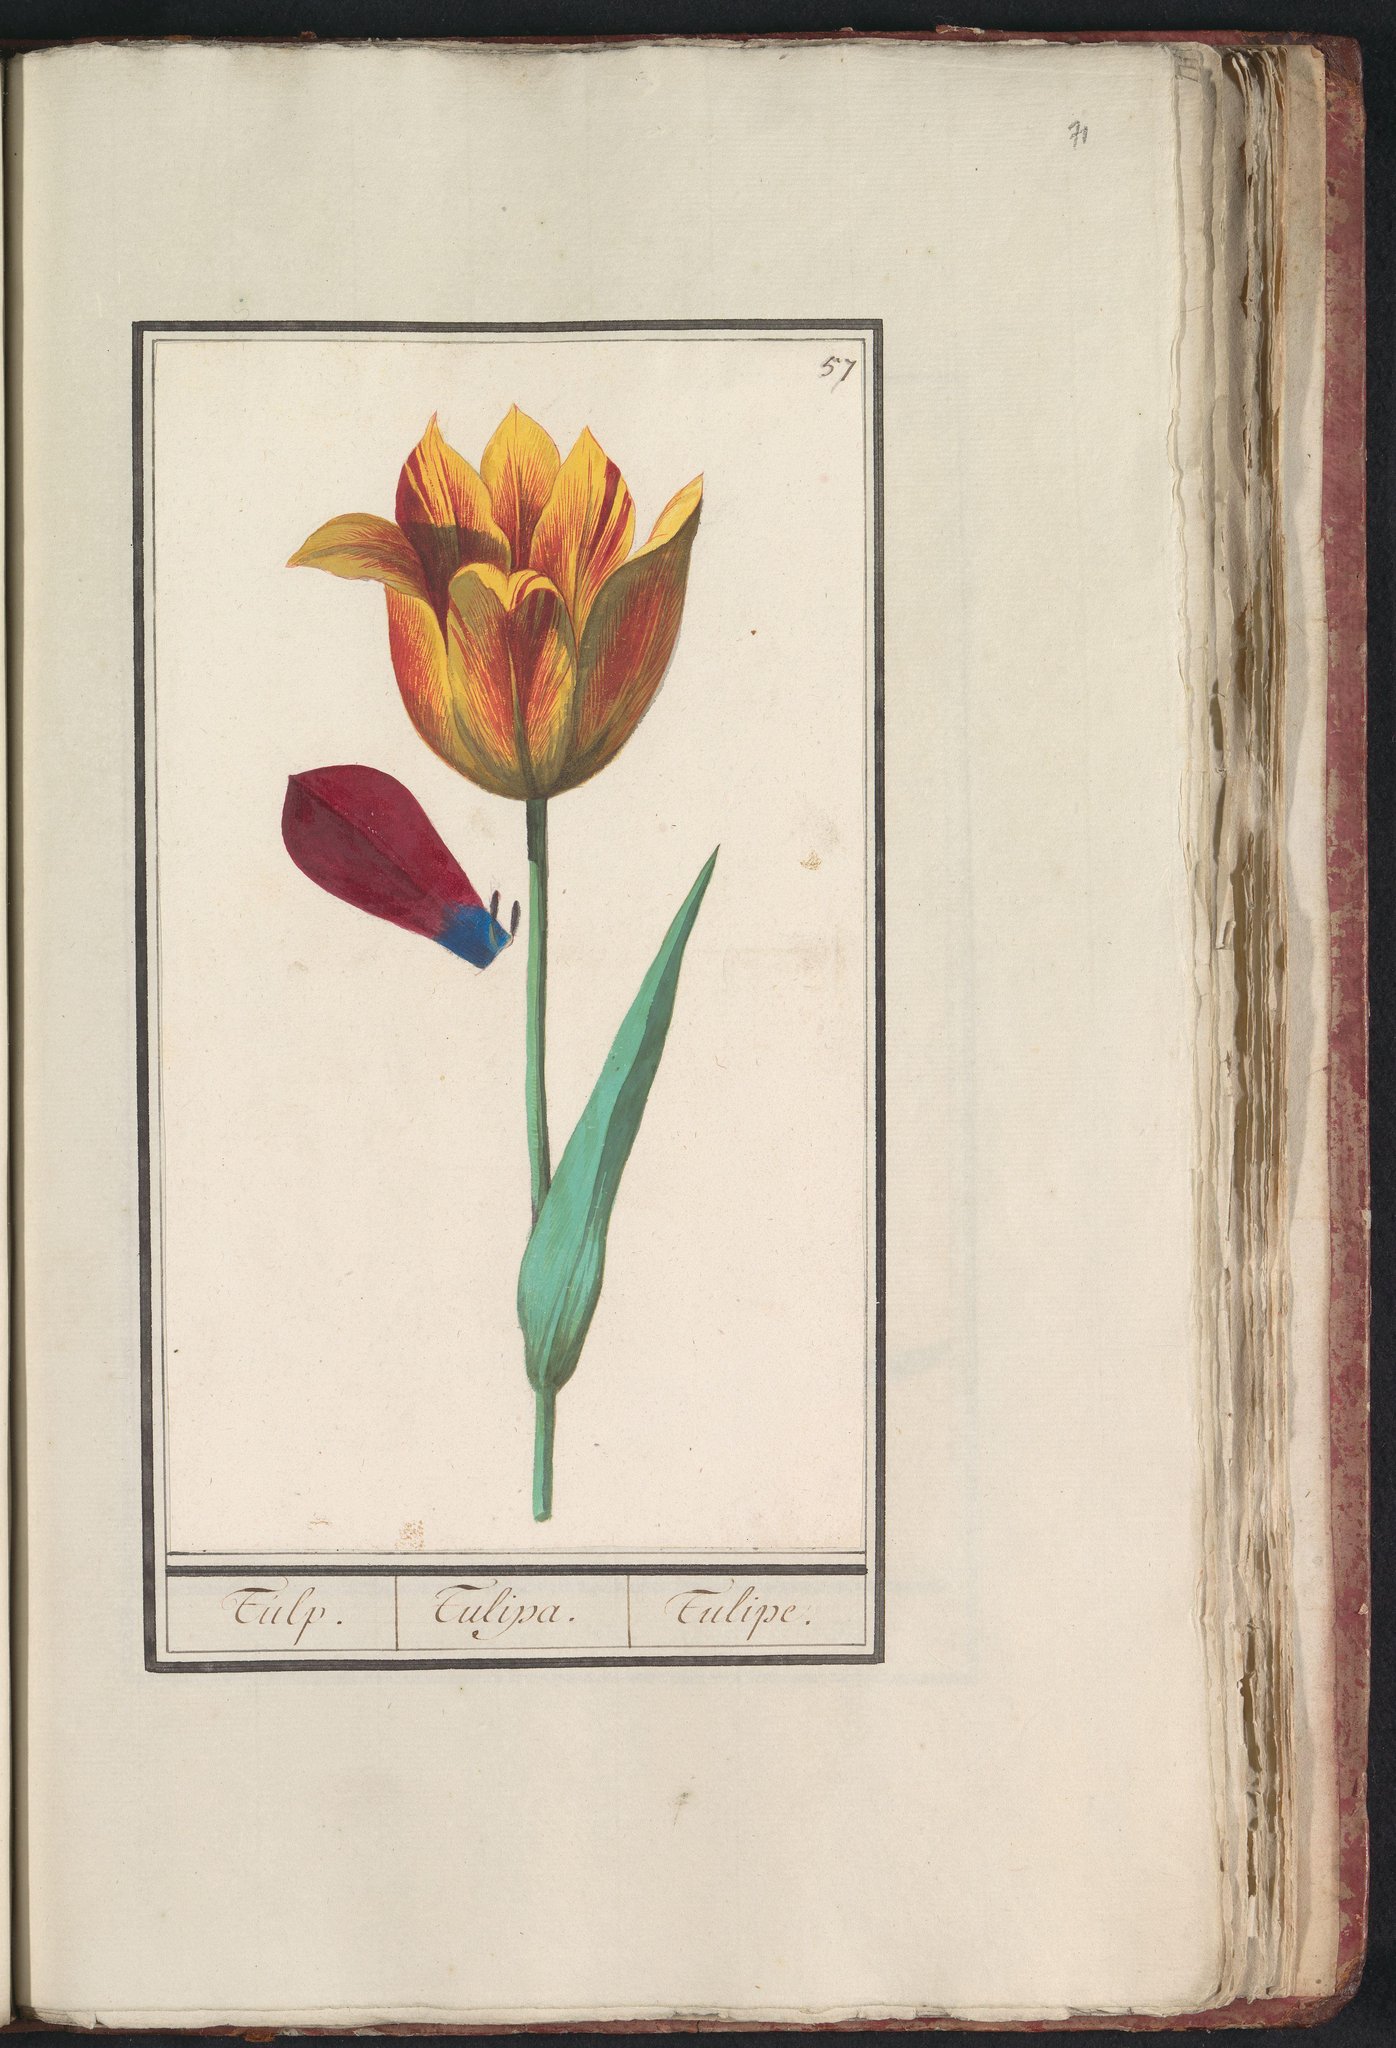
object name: drawing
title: Tulp (Tulipa)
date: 1596-1610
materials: chalk, paint, paper, watercolor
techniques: brush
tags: flowers: tulip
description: Geel-rode tulp en een detail van het bloemblad van een donkerrode tulp. Genummerd rechtsboven: 57. Onderdeel van het eerste album met tekeningen van bloemen en planten. Achtste van twaalf albums met tekeningen van dieren, vogels en planten bekend rond 1600, gemaakt in opdracht van keizer Rudolf II. Met toelichting in Nederlands, Latijn en Frans.